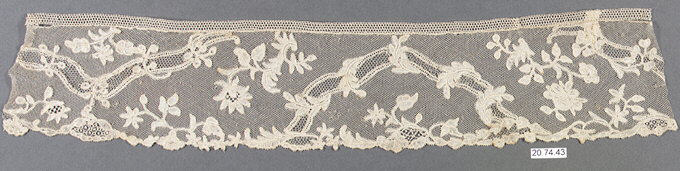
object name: piece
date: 1701-1800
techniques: lace